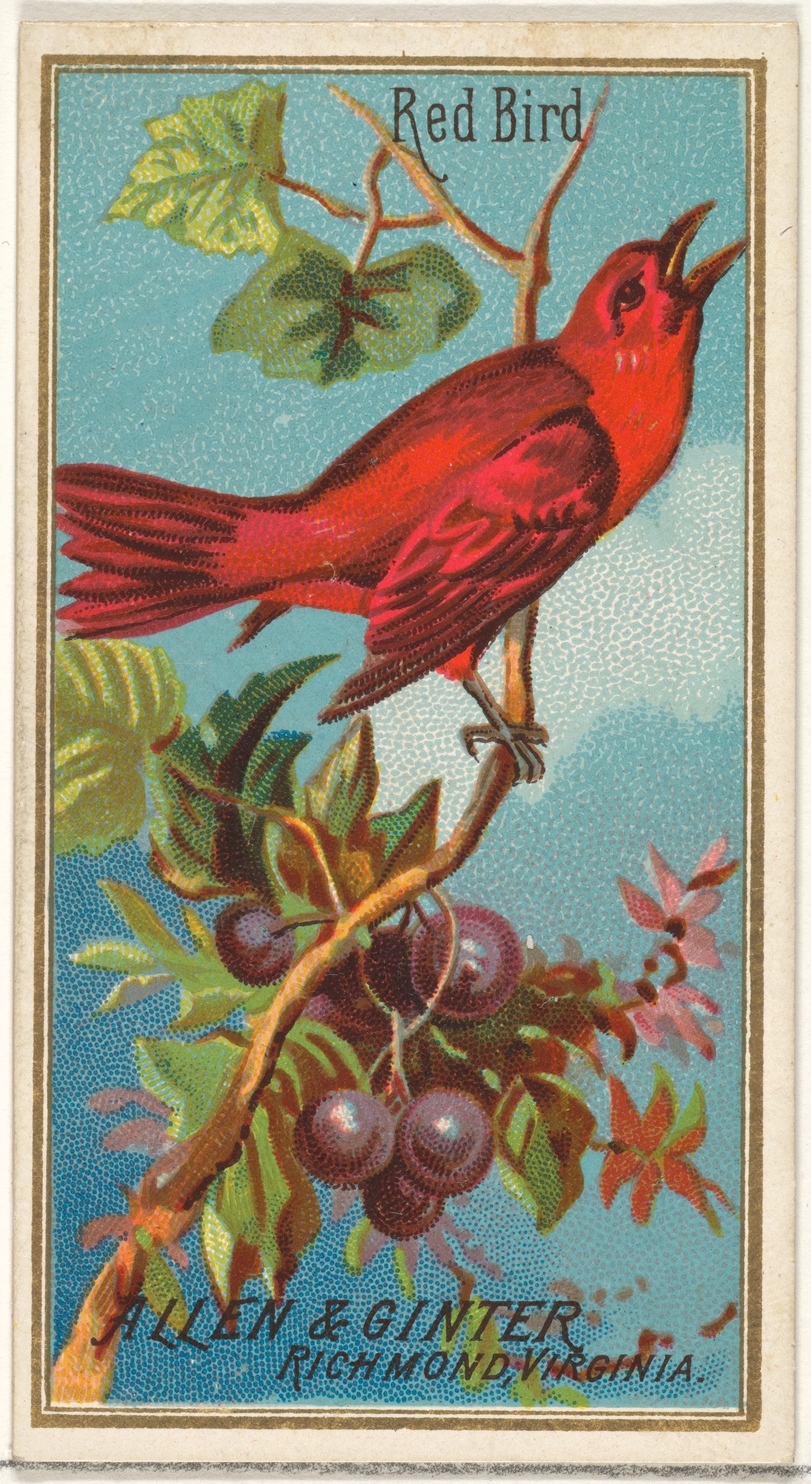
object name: print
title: Red Bird, from the Birds of America series (N4) for Allen & Ginter Cigarettes Brands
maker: allen & ginter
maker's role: publisher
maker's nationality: american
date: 1888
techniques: color lithograph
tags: birds